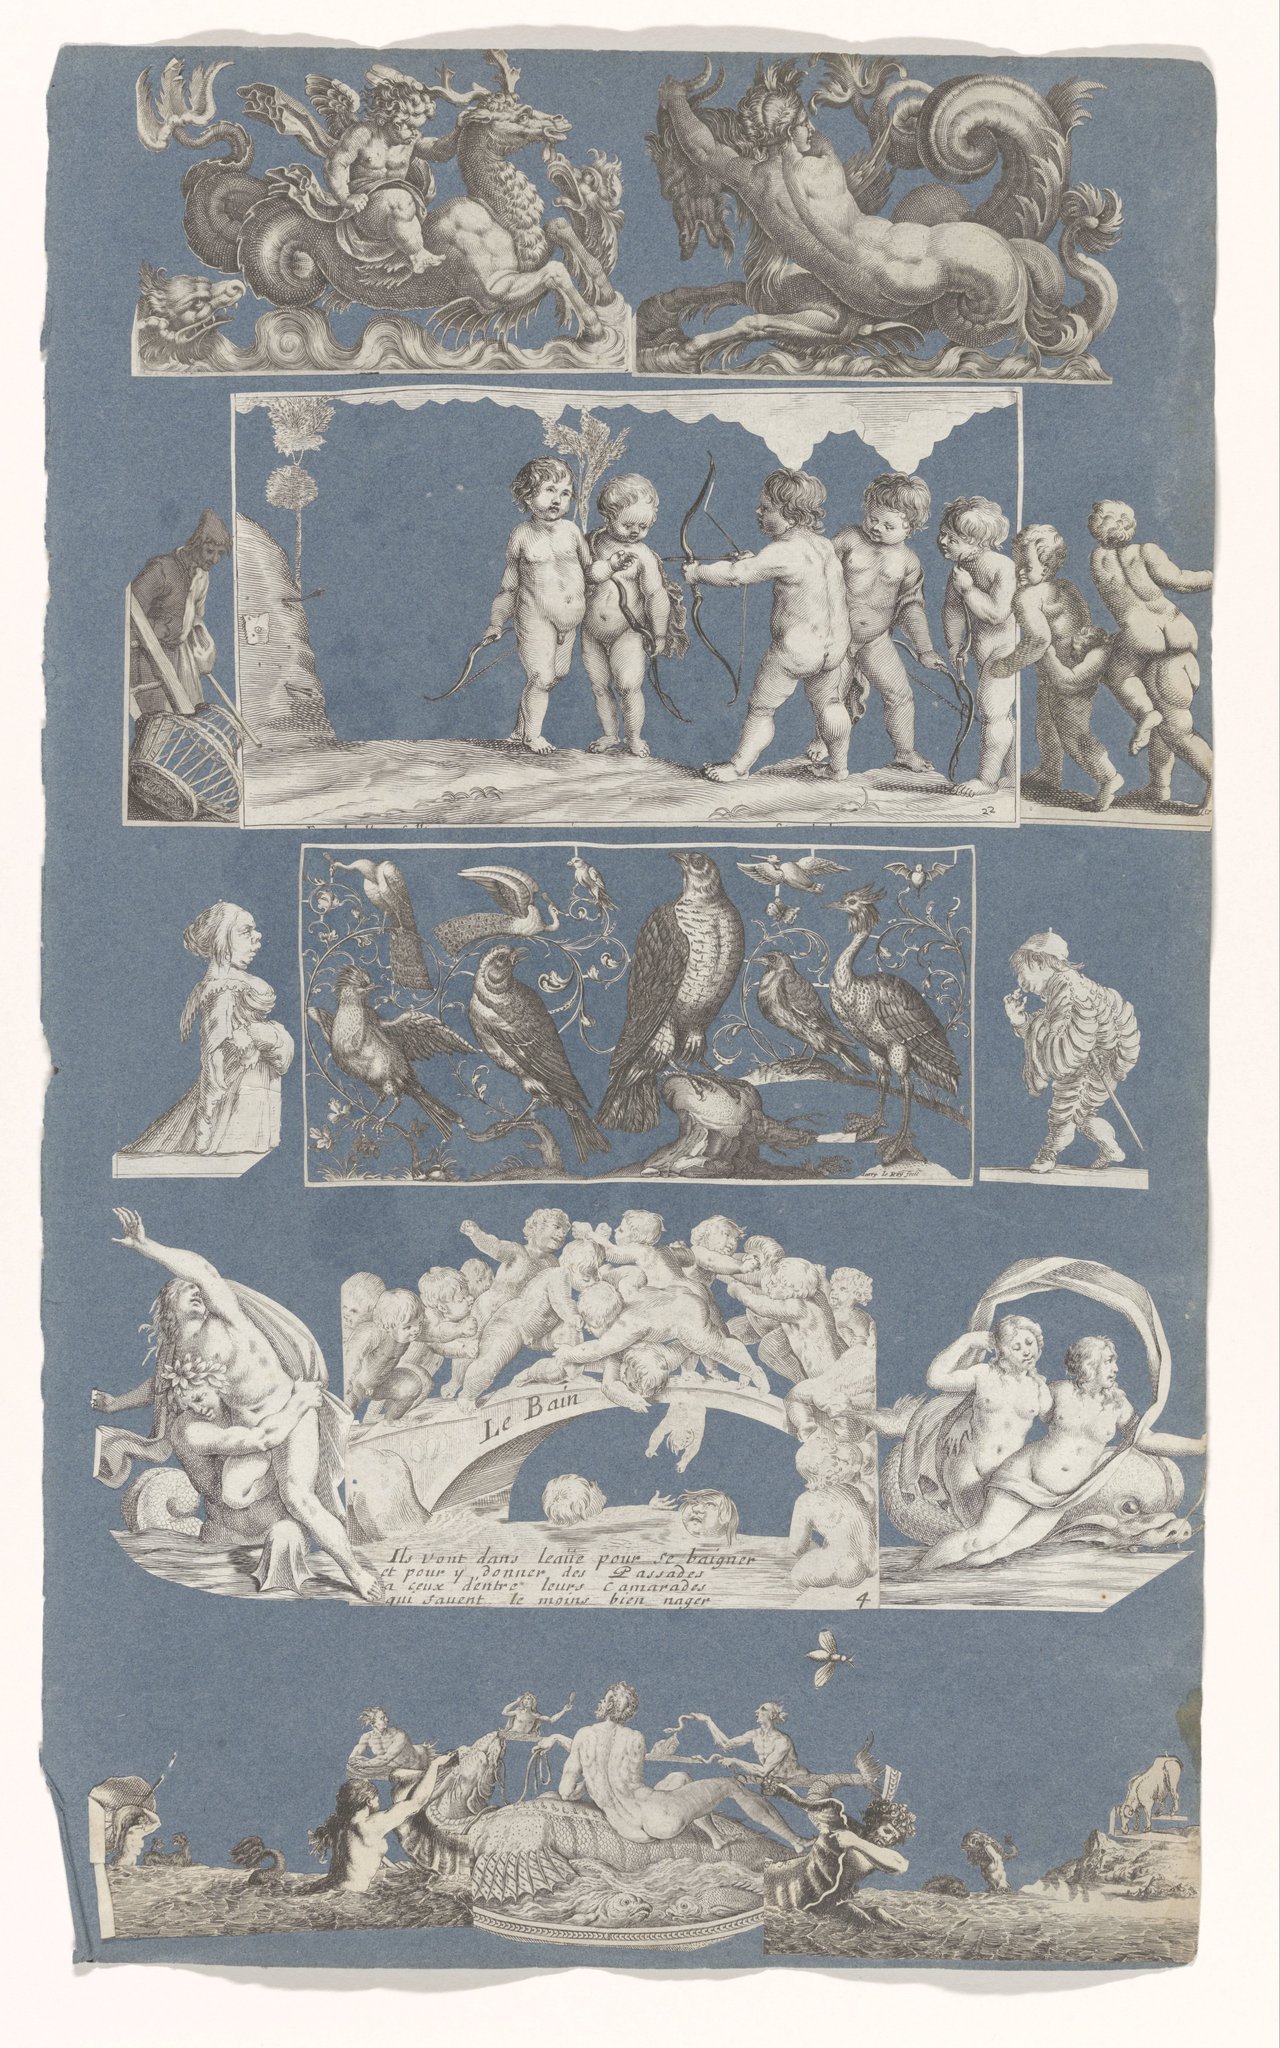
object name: print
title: Collage van uitgeknipte prenten geplakt op albumblad van blauw papier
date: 1585-1700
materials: paper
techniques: collage